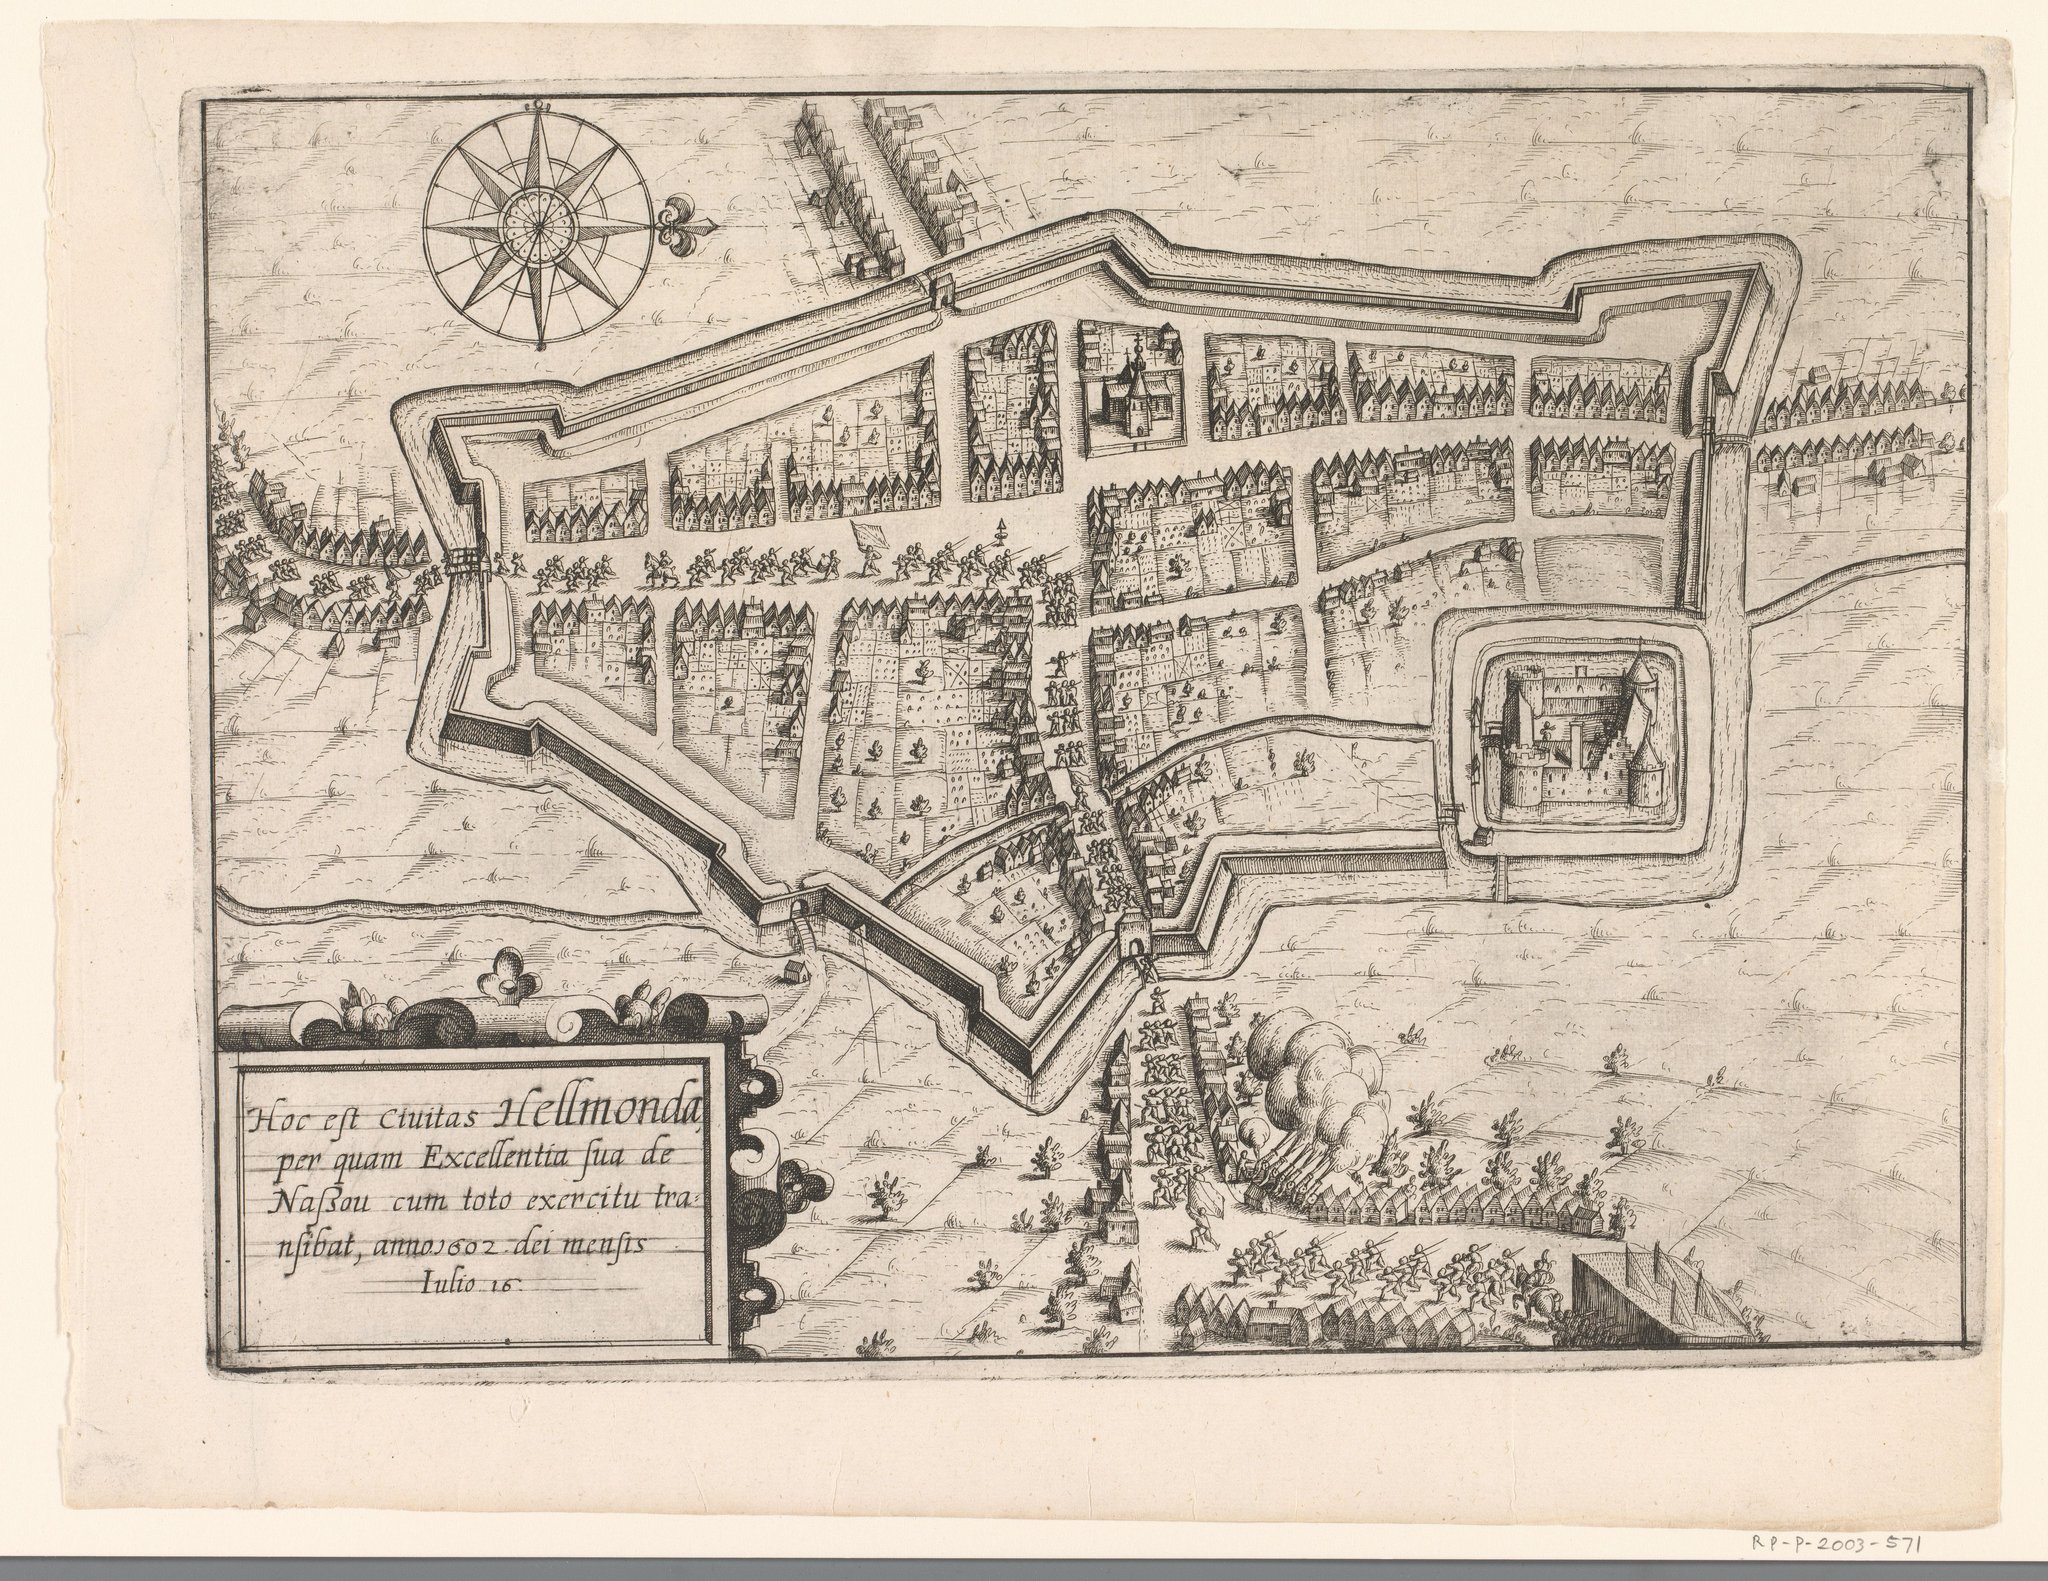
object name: history print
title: Leger van Maurits trekt door Helmond, 1602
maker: lambert cornelisz.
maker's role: draughtsman, print maker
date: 1607-1609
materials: paper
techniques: engraving, etching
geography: amsterdam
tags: the hague, maurice (prince of orange), marching away (troops) (+ land forces), transport, train (military), maps of cities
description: Plattegrond van Helmond in vogelvluchtperspectief, waarop te zien is dat het Staatse leger onder prins Maurits, op 16 juli 1602, door de stad heen trekt. Linksonder de titelcartouche met Latijnse tekst. Onderdeel van de verzameling kaarten genomen uit een latere editie van: Descrittione di tutti i Paesi Bassi van Lodovico Guicciardini.